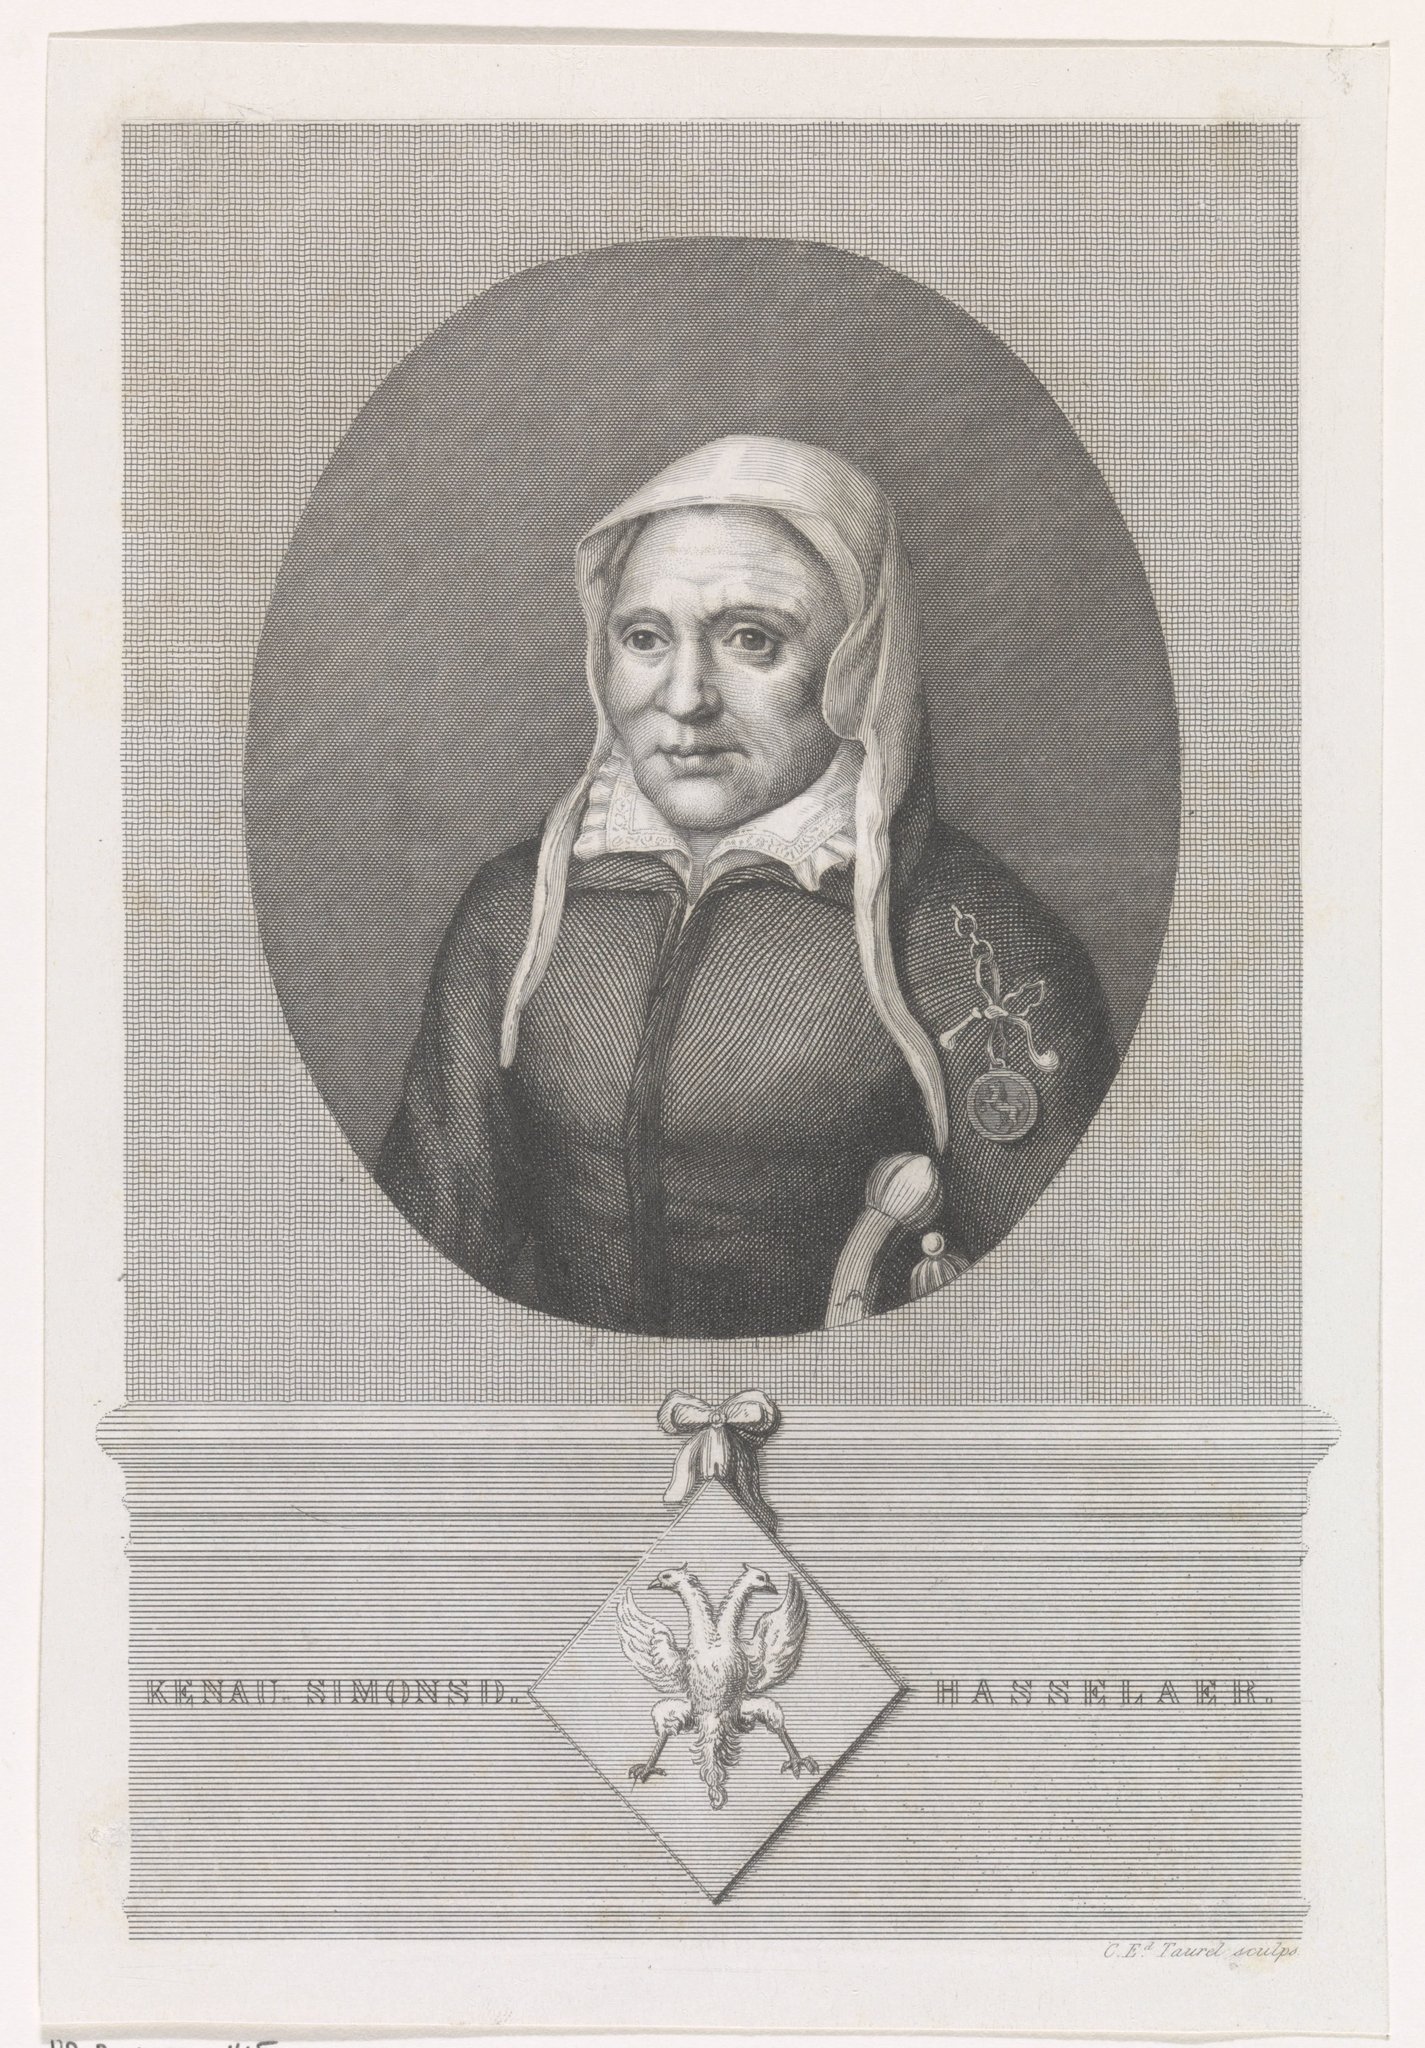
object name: print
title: Portret van Kenau Simonsdochter Hasselaar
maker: edouard taurel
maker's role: draughtsman, print maker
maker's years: 1824-1892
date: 1841-1879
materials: paper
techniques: engraving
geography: amsterdam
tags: haarlem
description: Prent ook gebruikt als illustratie voor: Arend, Johannes Pieter. Algemeene geschiedenis des vaderlands van de vroegste tijden tot op heden. 5 delen. Amsterdam: J.F. Schleijer, 1841-1884. dl. II.5, p. 246.